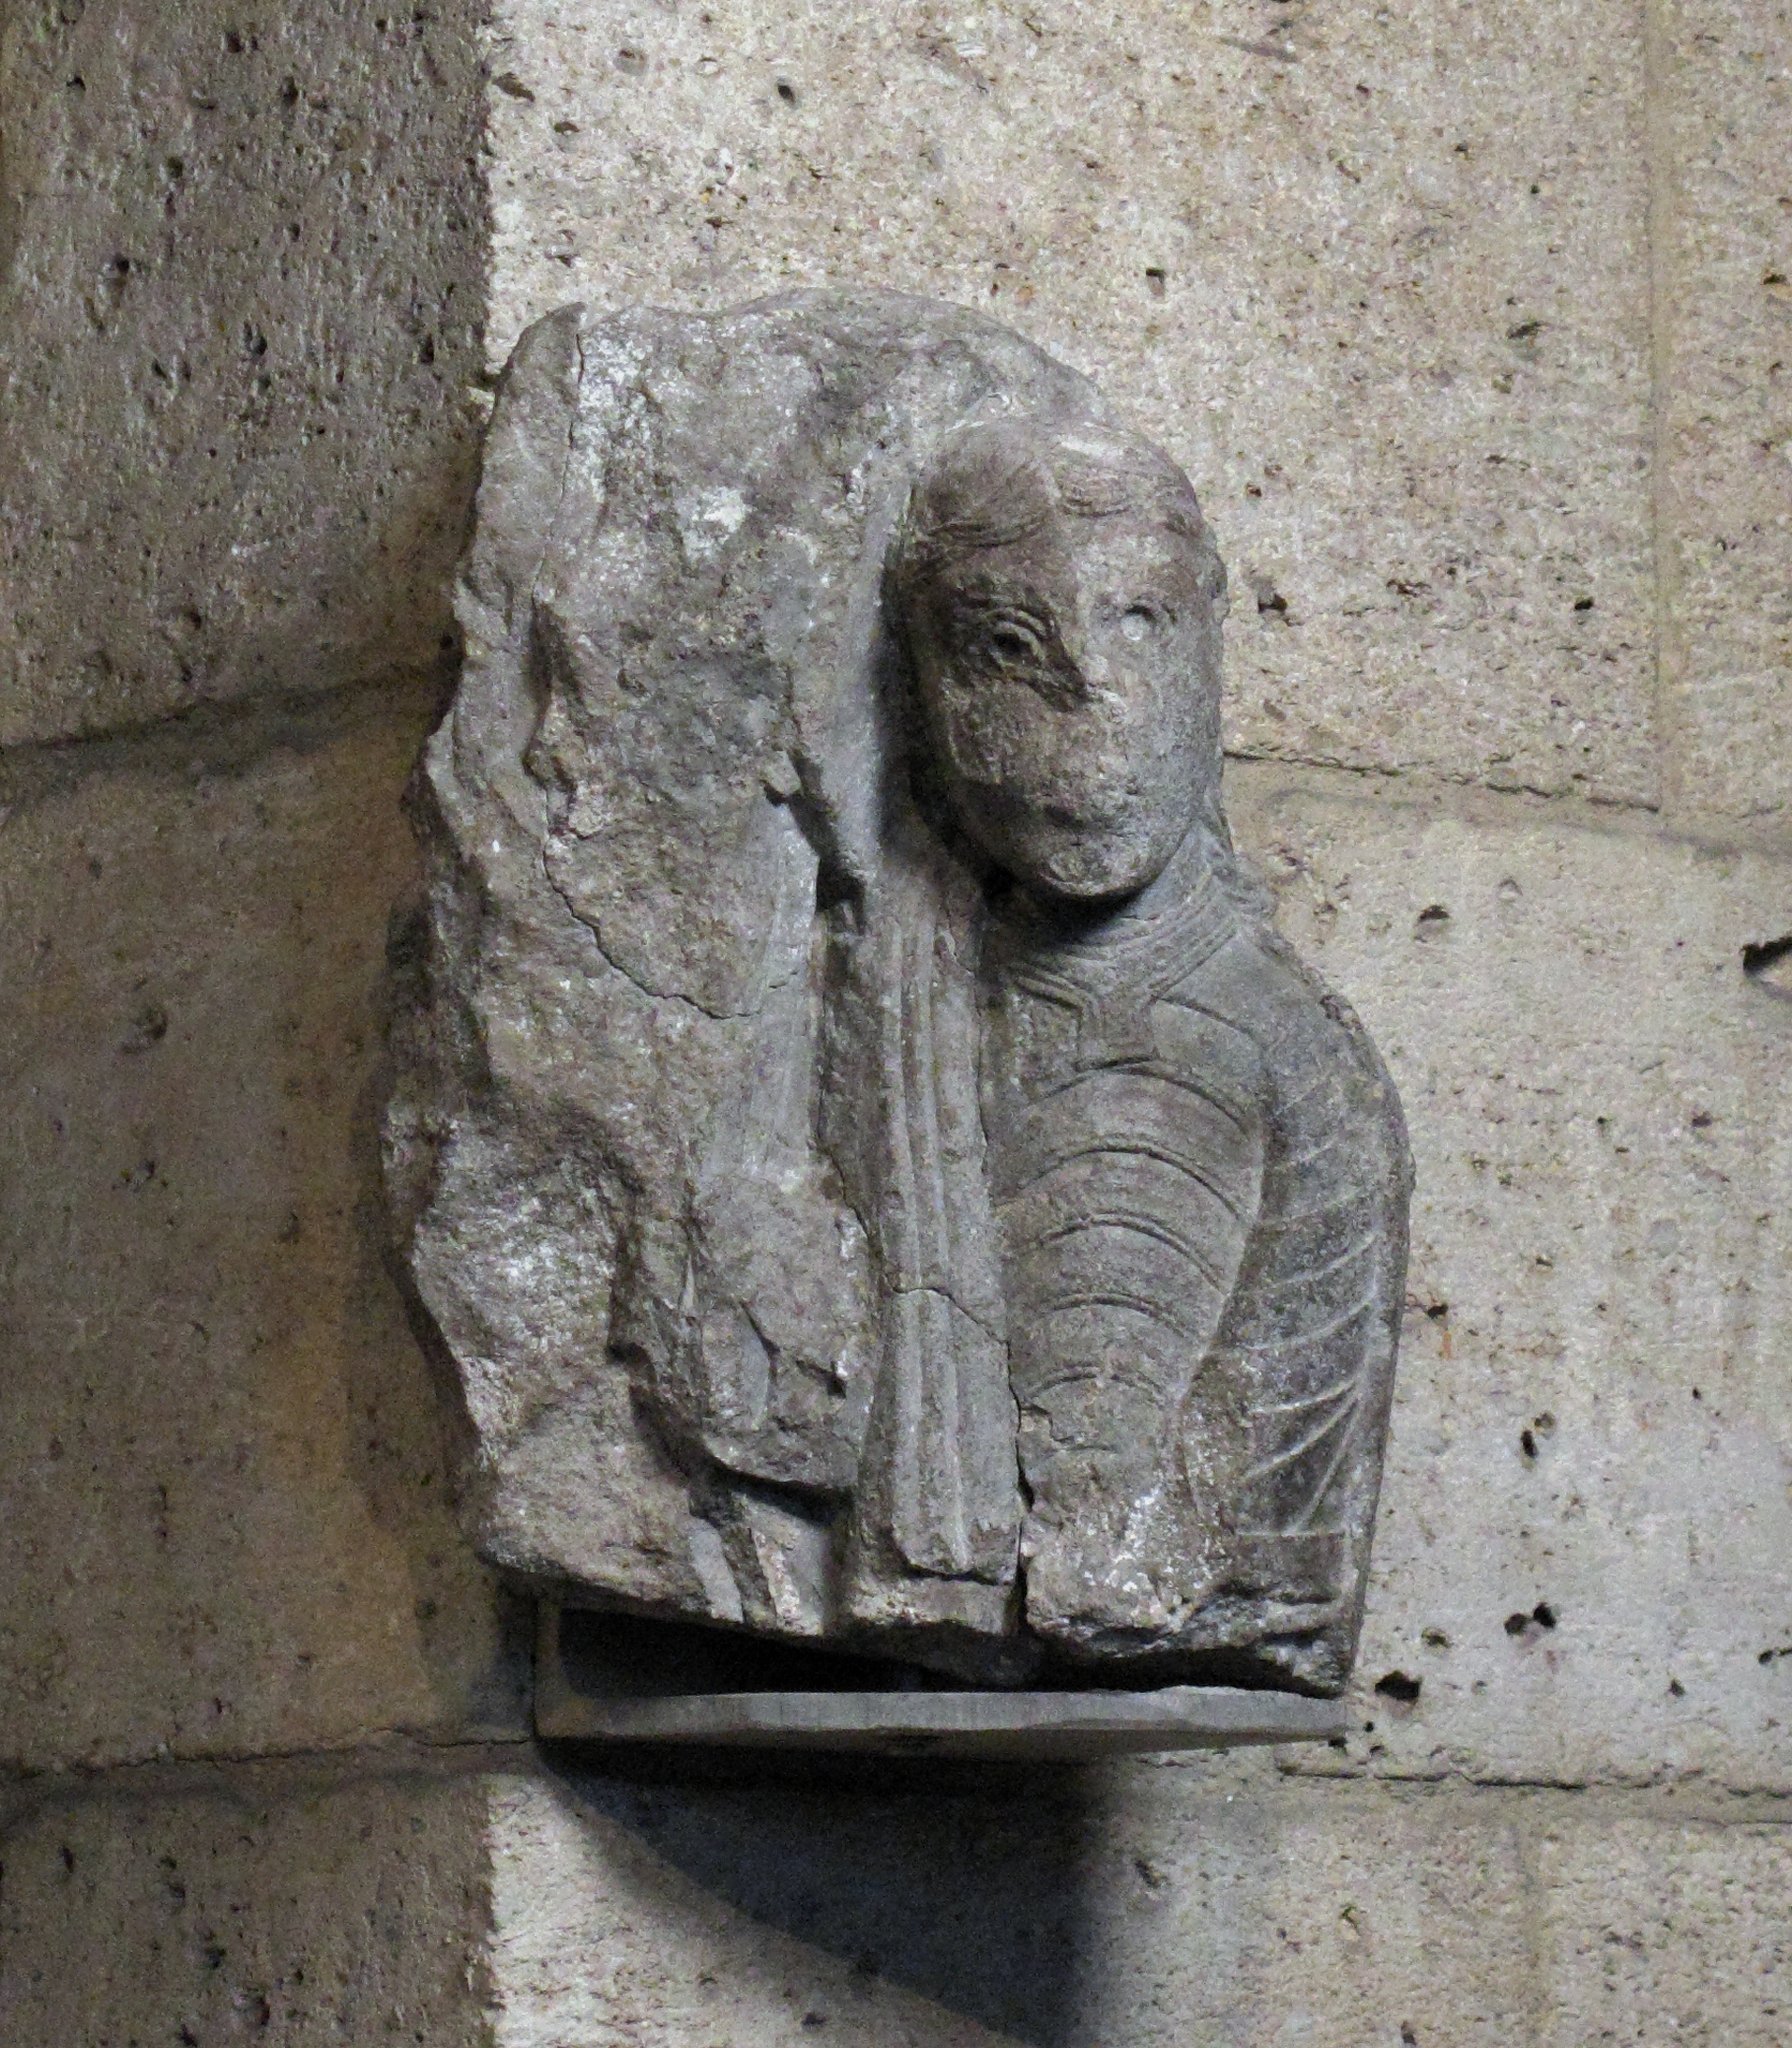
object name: sculpture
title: Angel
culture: french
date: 1120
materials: limestone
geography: france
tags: angels